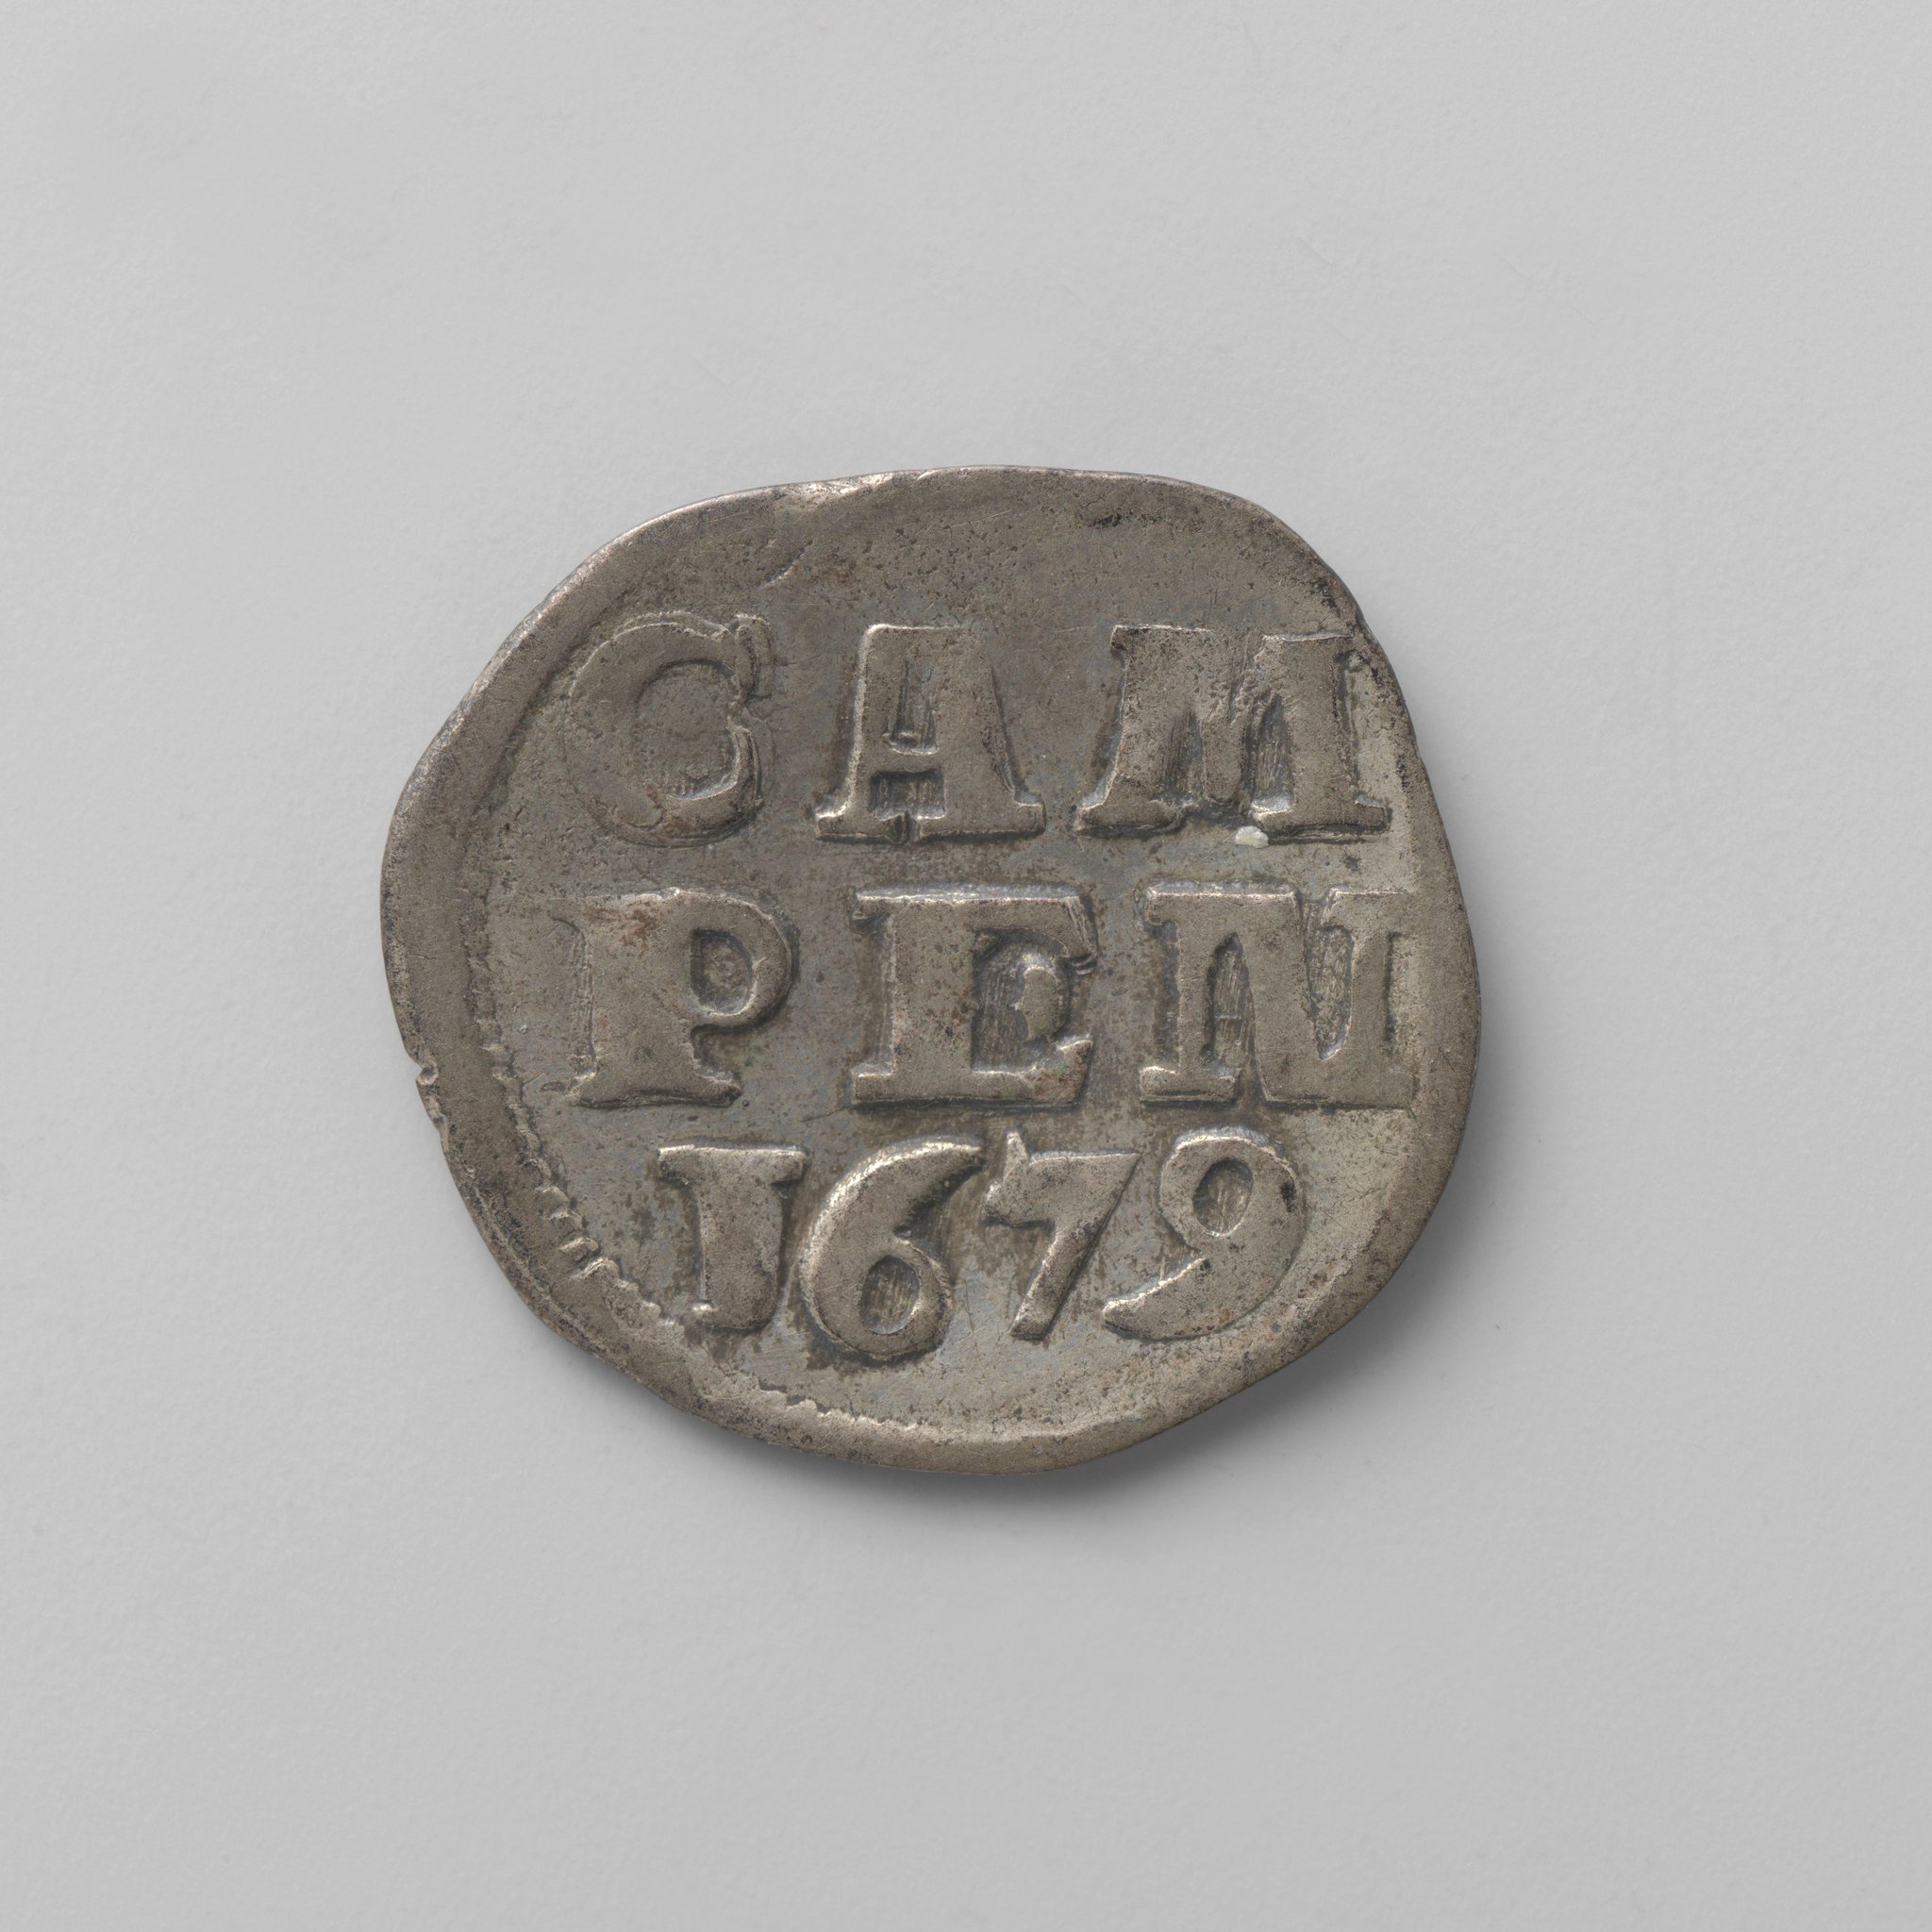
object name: coin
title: Kampen, dubbele stuiver, 1679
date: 1679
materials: silver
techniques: striking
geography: kampen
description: Zilveren munt. Voorzijde: tussen waarde-aanduiding 2 S generaliteitsleeuw. Keerzijde: tweeregelig opschrift, waaronder jaartal.